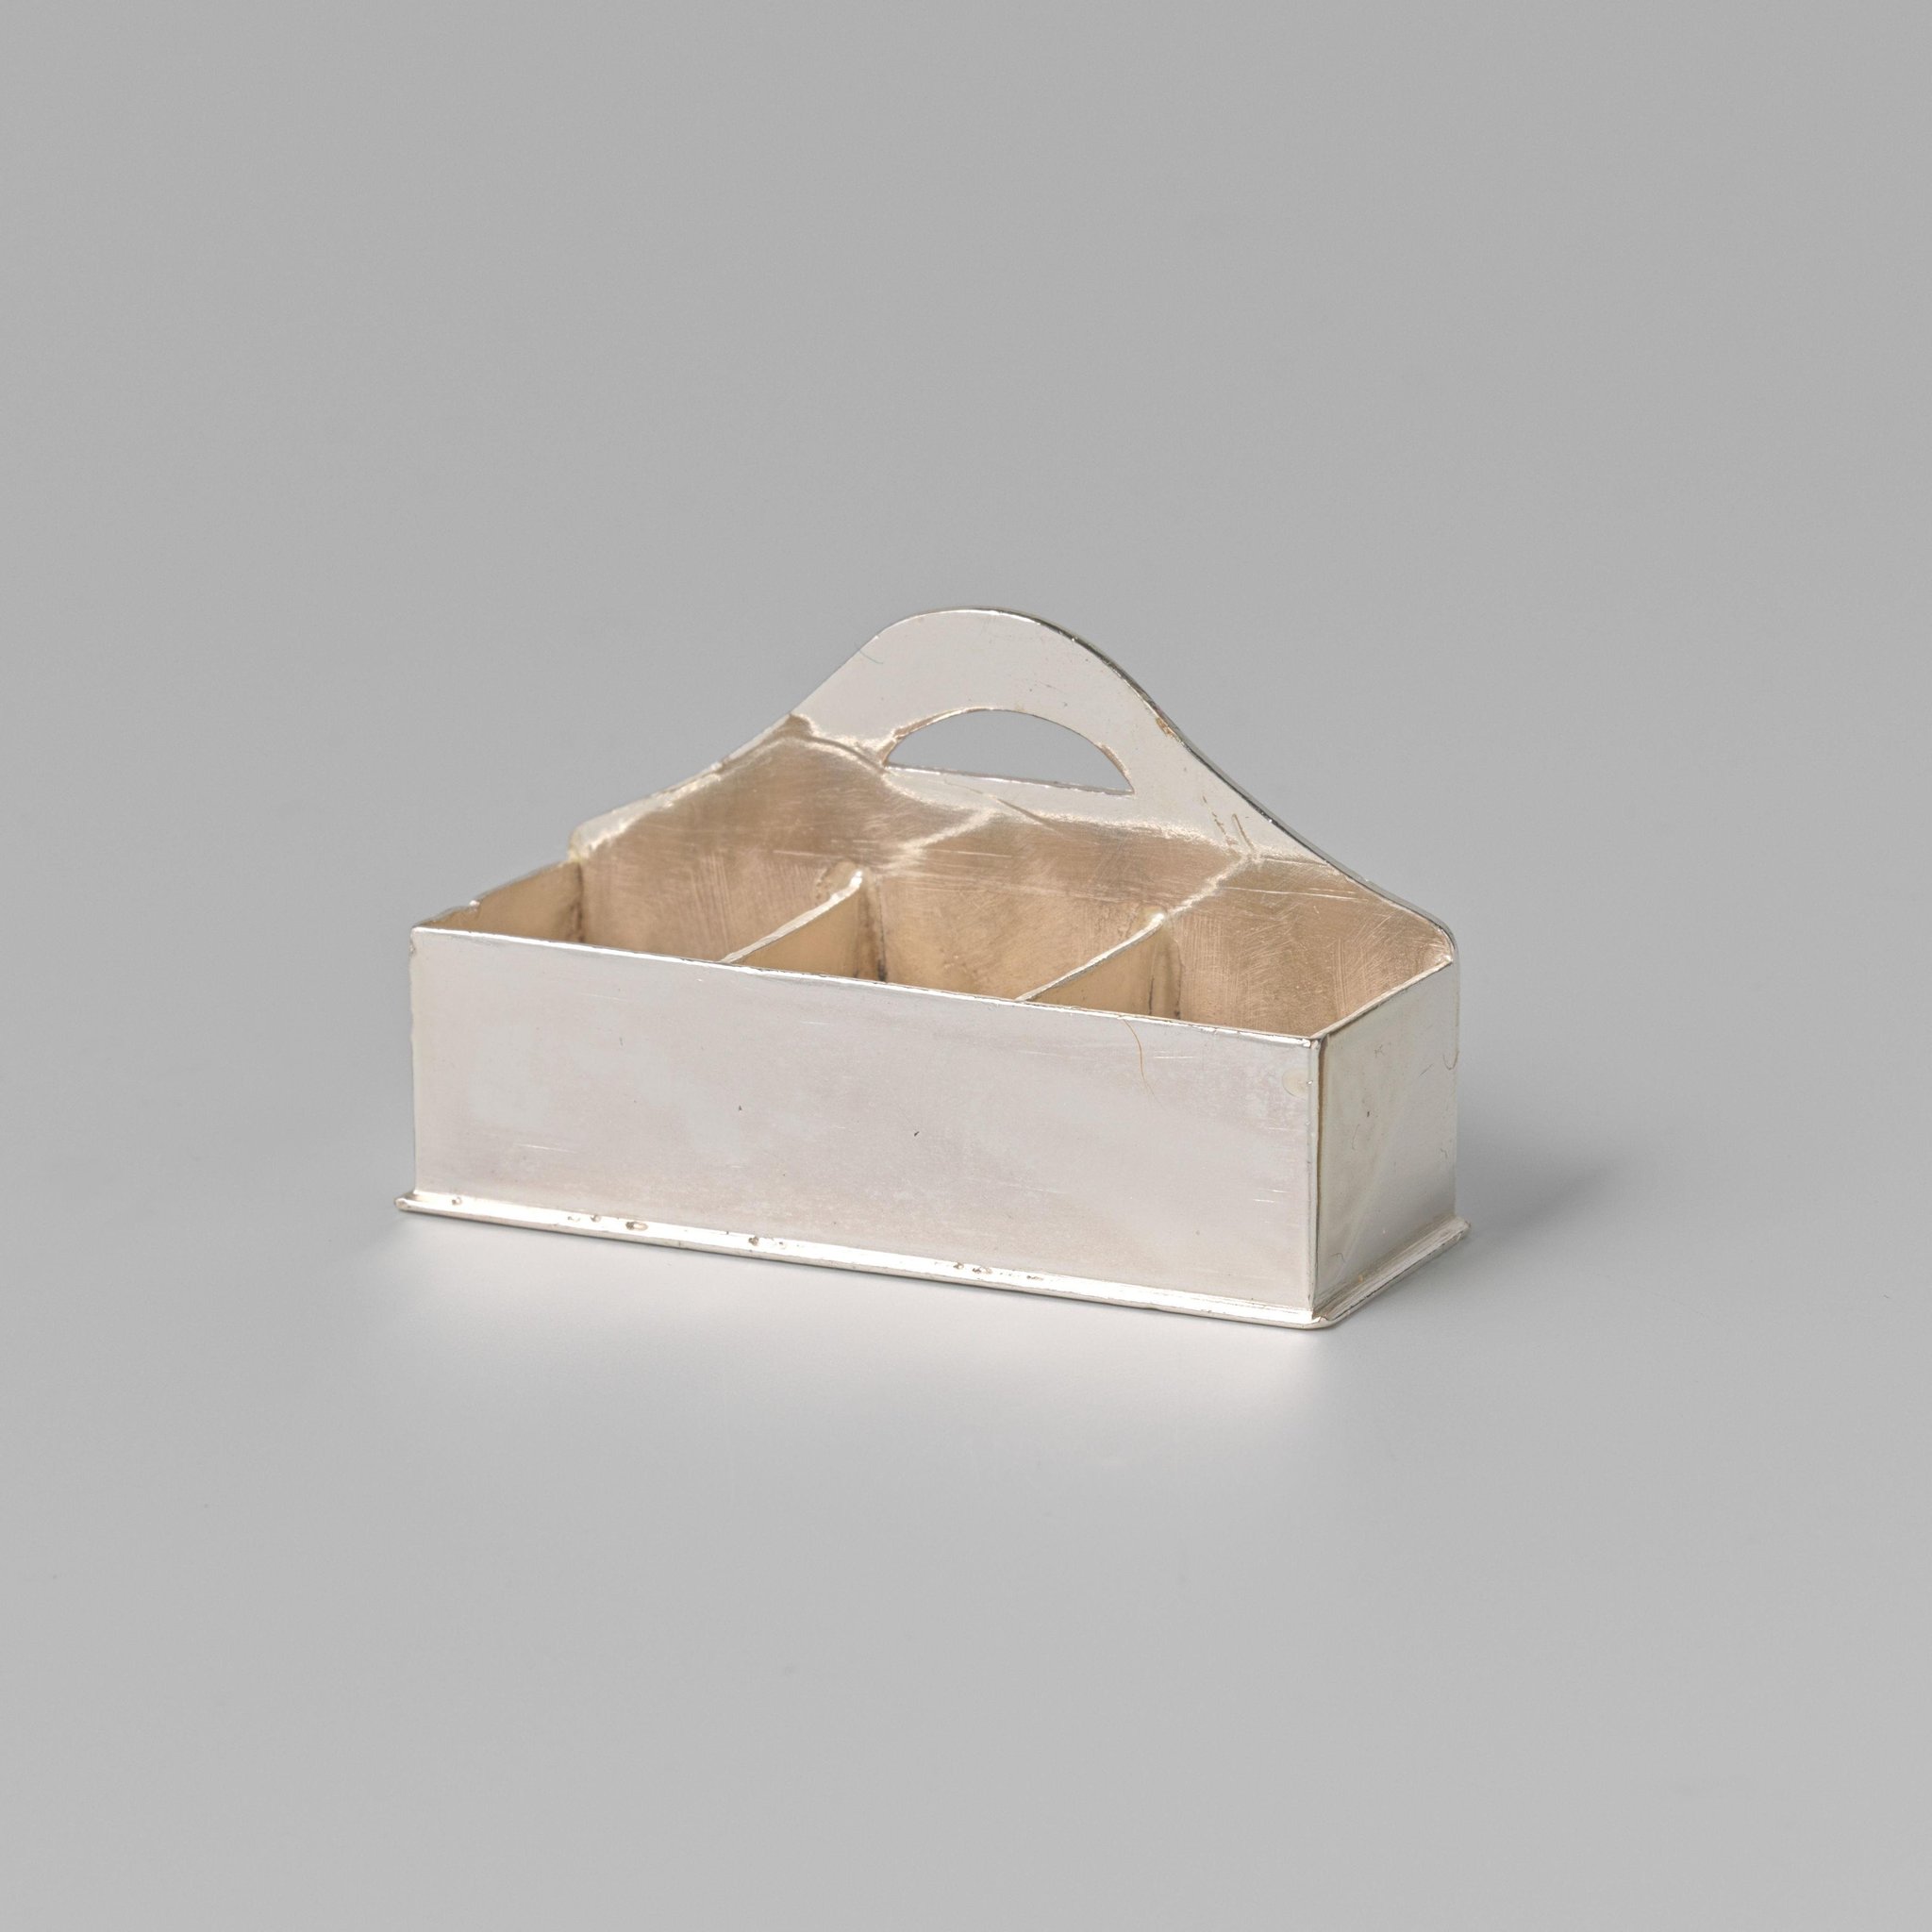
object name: miniature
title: Wandbak van zilver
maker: frederik van strant (i)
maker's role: silversmith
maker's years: 1678-1727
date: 1706-1727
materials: silver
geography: amsterdam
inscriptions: duty mark: ‘bijltje’, town mark: ‘kleine stadskeur Amsterdam’, maker's mark: ‘FS (Citroen 1975, nr. 231)’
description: Wandbak van zilver met drie vakjes, onversierd met breed oog om het aan de wand te bevestigen.